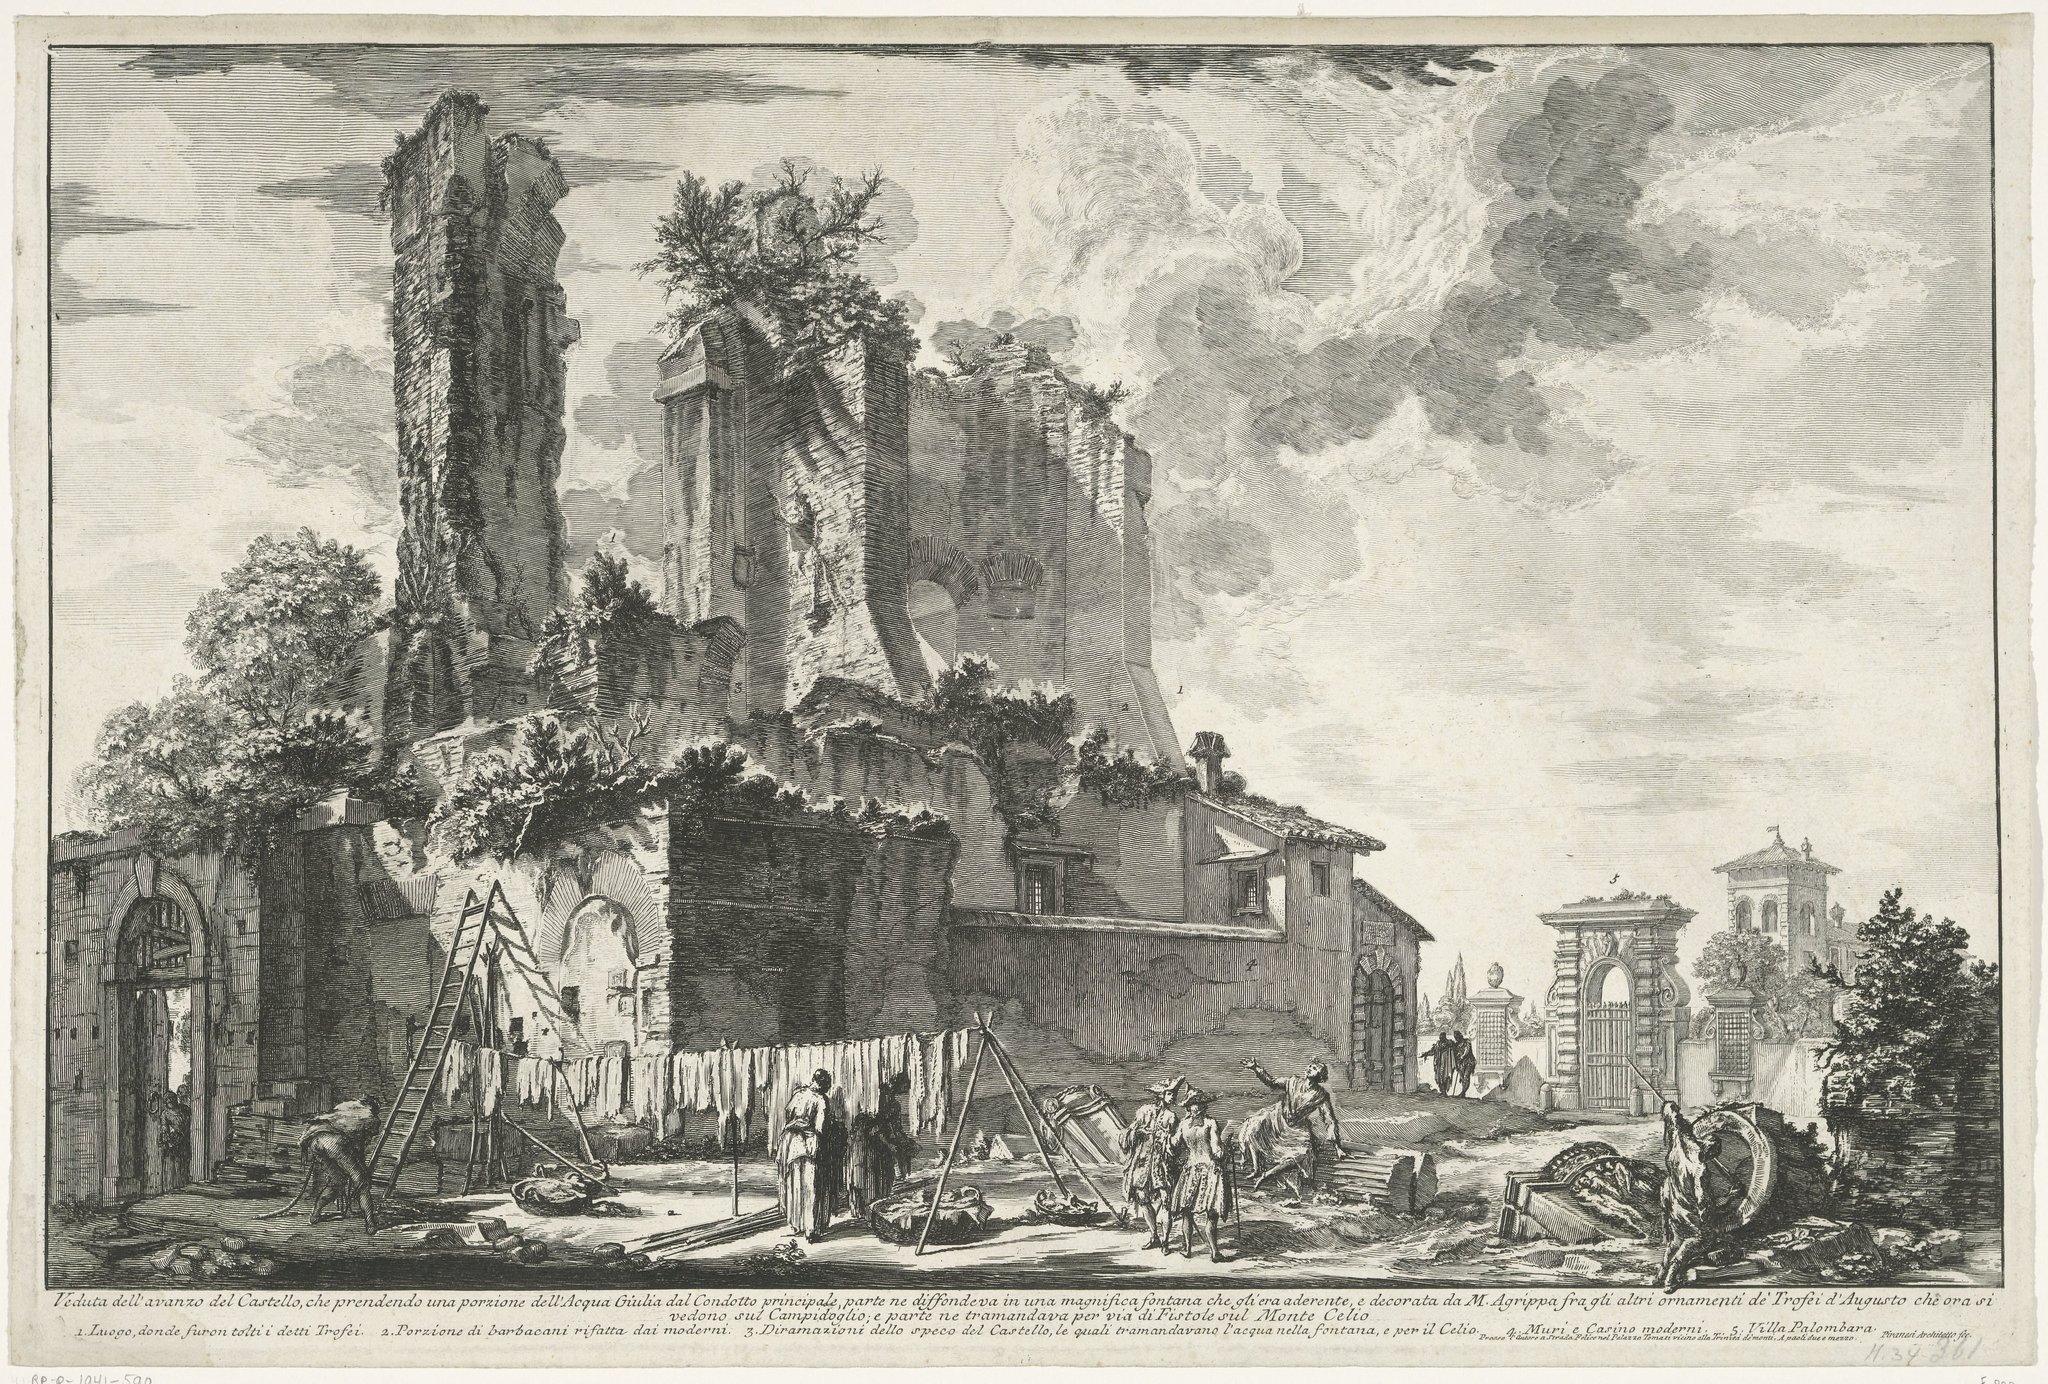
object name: print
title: Vedute di Roma disegnate ed incise da Giambattista Piranesi architetto Ve(nez)iano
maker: giovanni battista piranesi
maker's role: designer, draughtsman, print maker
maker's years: 1720-1778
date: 1748-1778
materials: paper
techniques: etching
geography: rome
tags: city-view, and landscape with man-made constructions, landscape with bridge, viaduct or aqueduct, landscape with ruins, aqueduct (~ water supply), rome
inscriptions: collector's mark: Lugt 2228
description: Deze prent maakt deel uit van de serie 'Vedute di Roma'. Piranesi werkte aan deze 135 platen tellende serie tussen 1748 en zijn dood in 1778. Francesco Piranesi voegde later nog twee prenten toe aan de reeks van zijn vader.